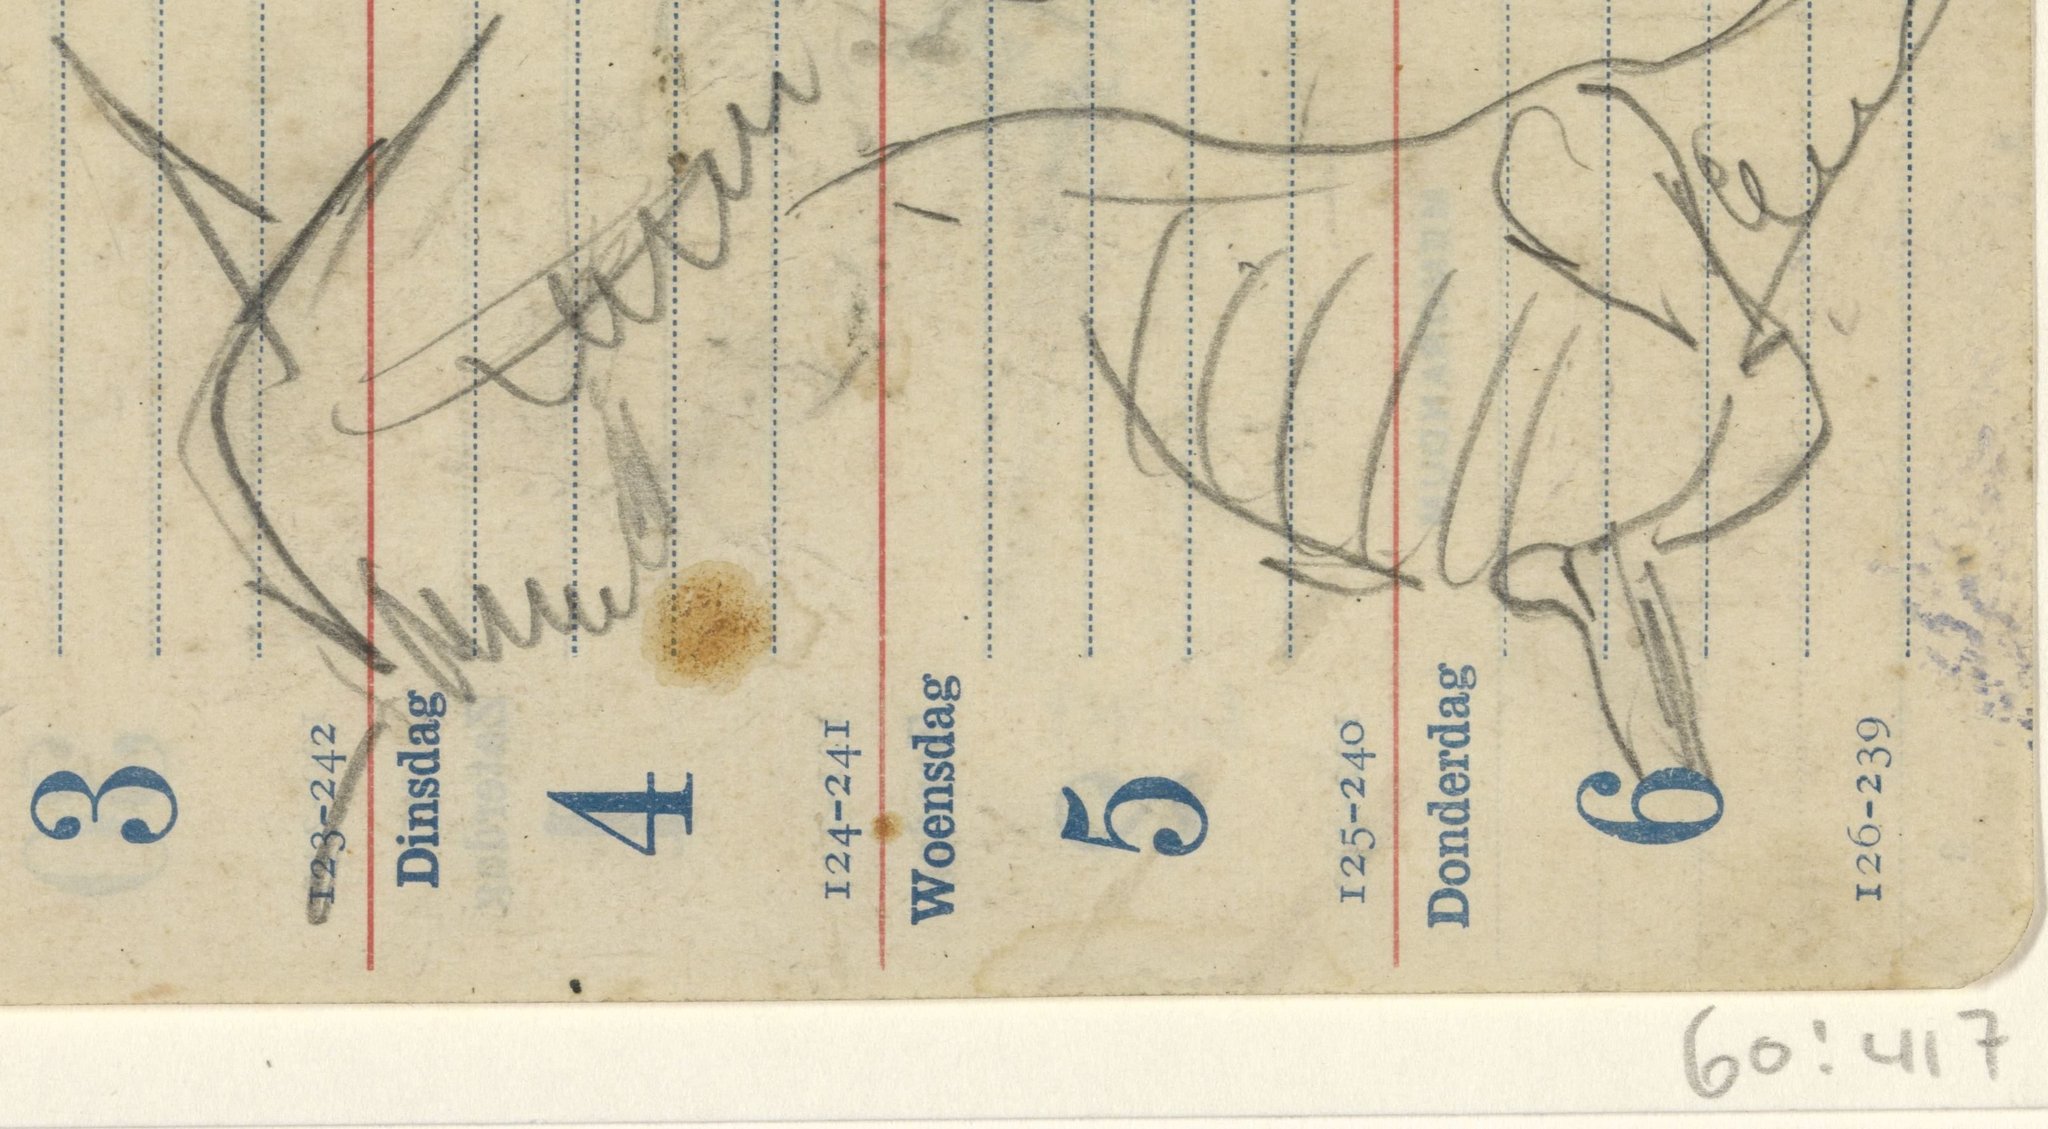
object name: drawing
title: Ribbenkast van een paard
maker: leo gestel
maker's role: draughtsman, print maker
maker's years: 1881-1941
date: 1926-1941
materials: paper, pencil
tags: horse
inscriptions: collector's mark: Lugt 2228